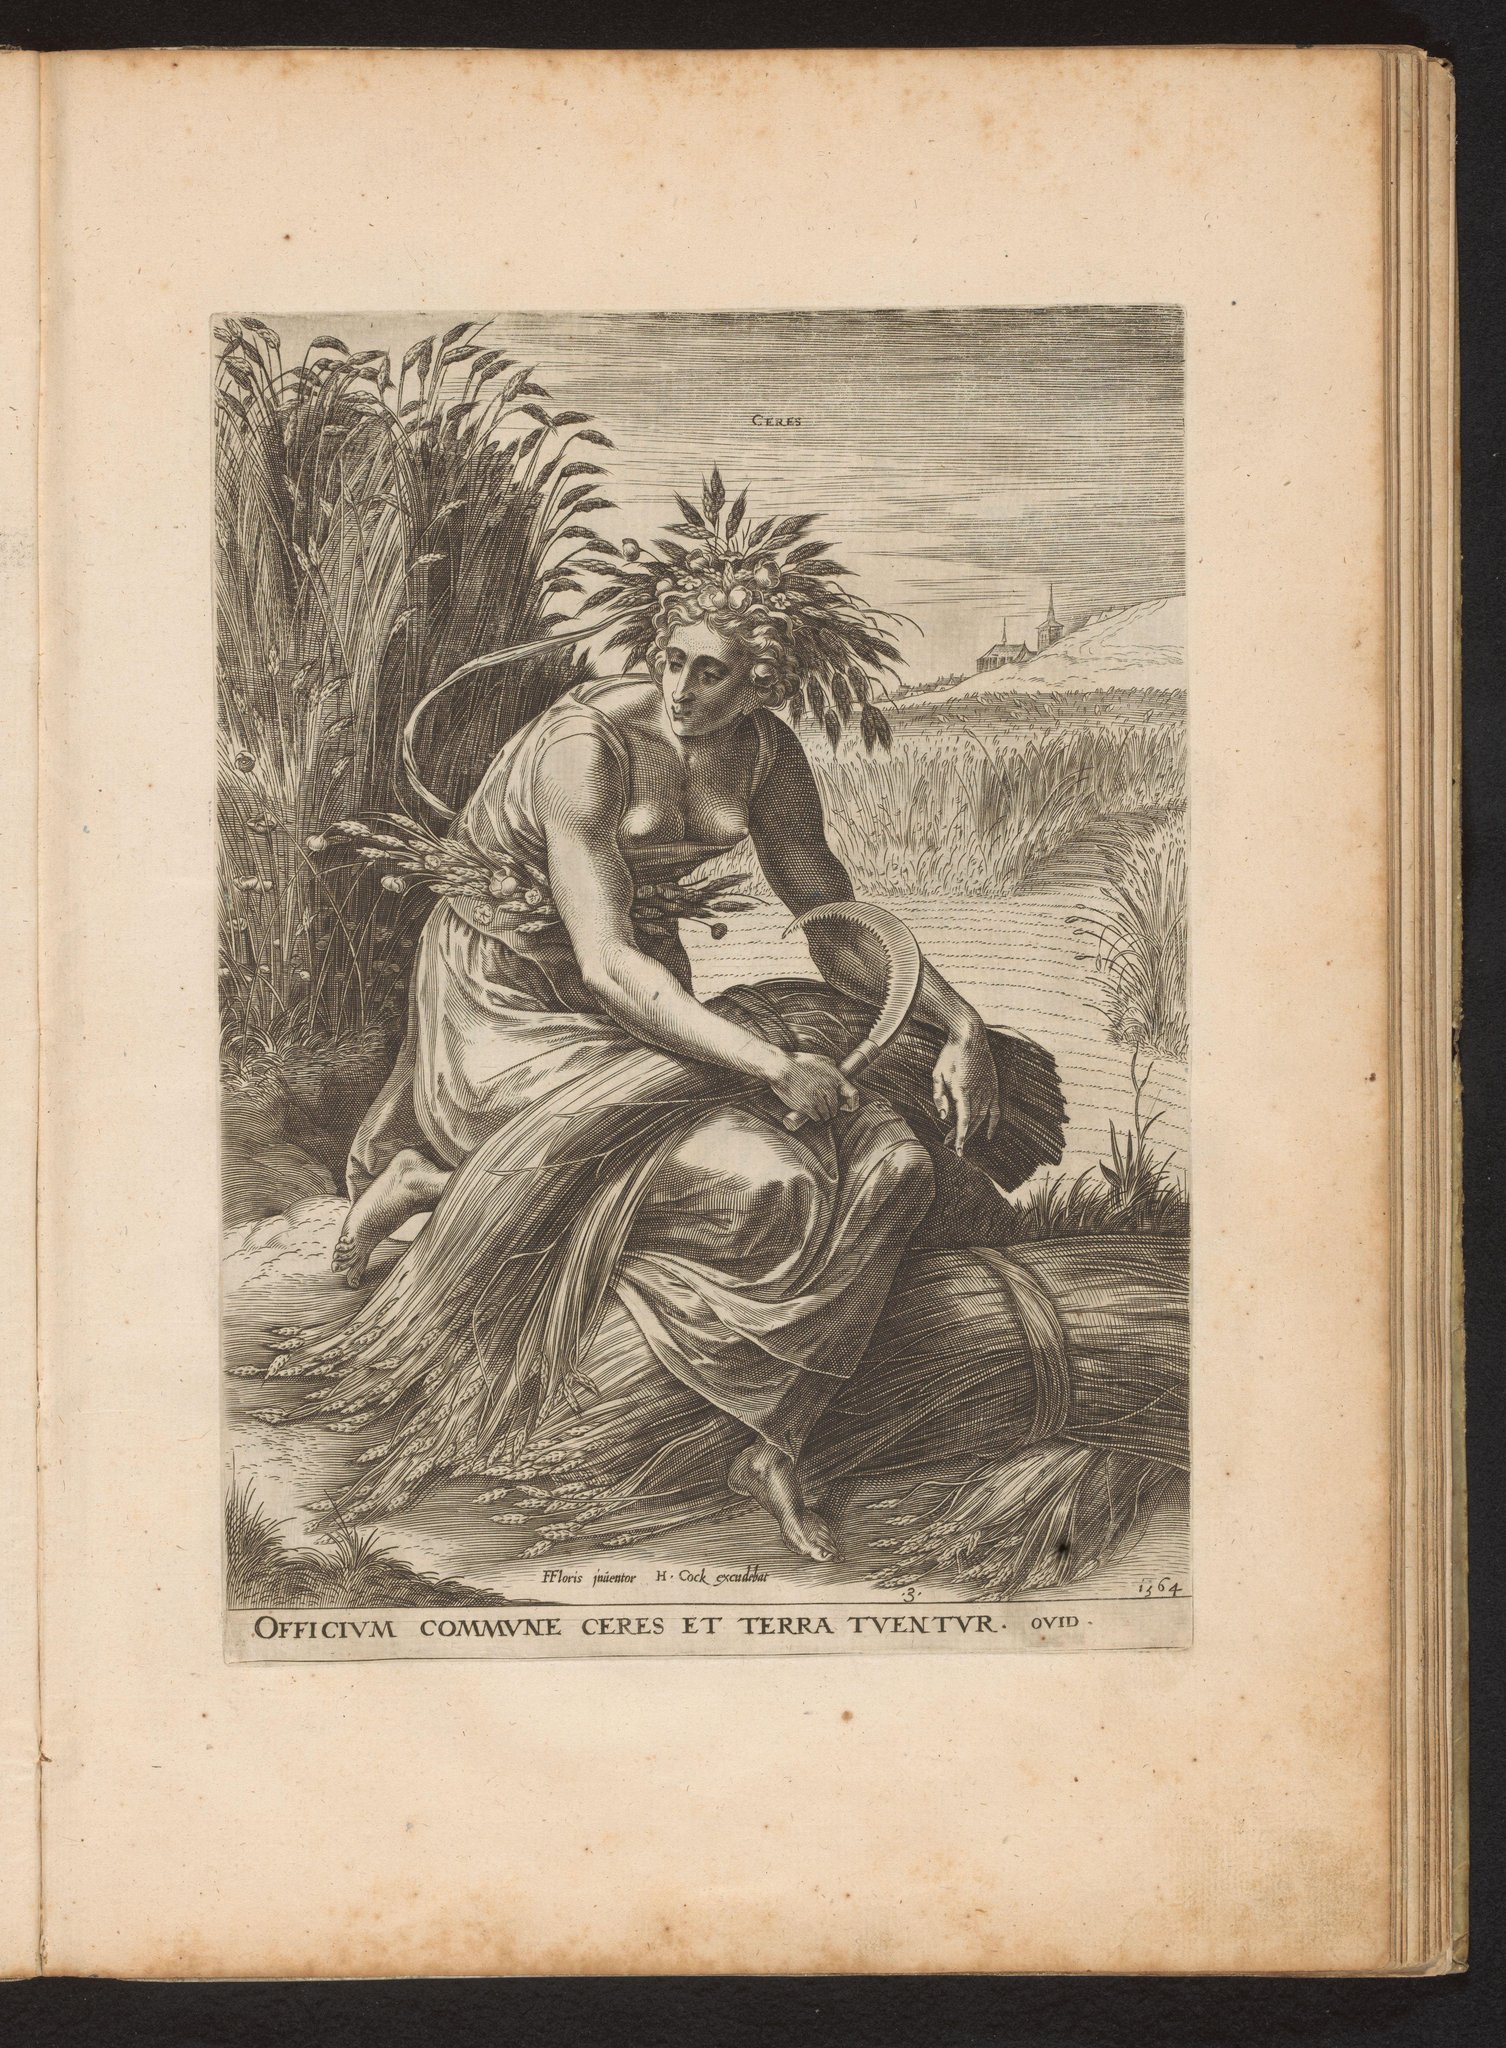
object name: print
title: Ceres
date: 1564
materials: paper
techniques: engraving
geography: antwerp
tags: (story of) ceres (demeter), sheaf, attributes of ceres: sickle, agricultural implements: sickle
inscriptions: date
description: Ceres, de godin van de landbouw en het graan. Zittend oogstend in een graanveld met een korenschoof op schoot, sikkel in de hand. Deze prent maakt deel uit van een album.